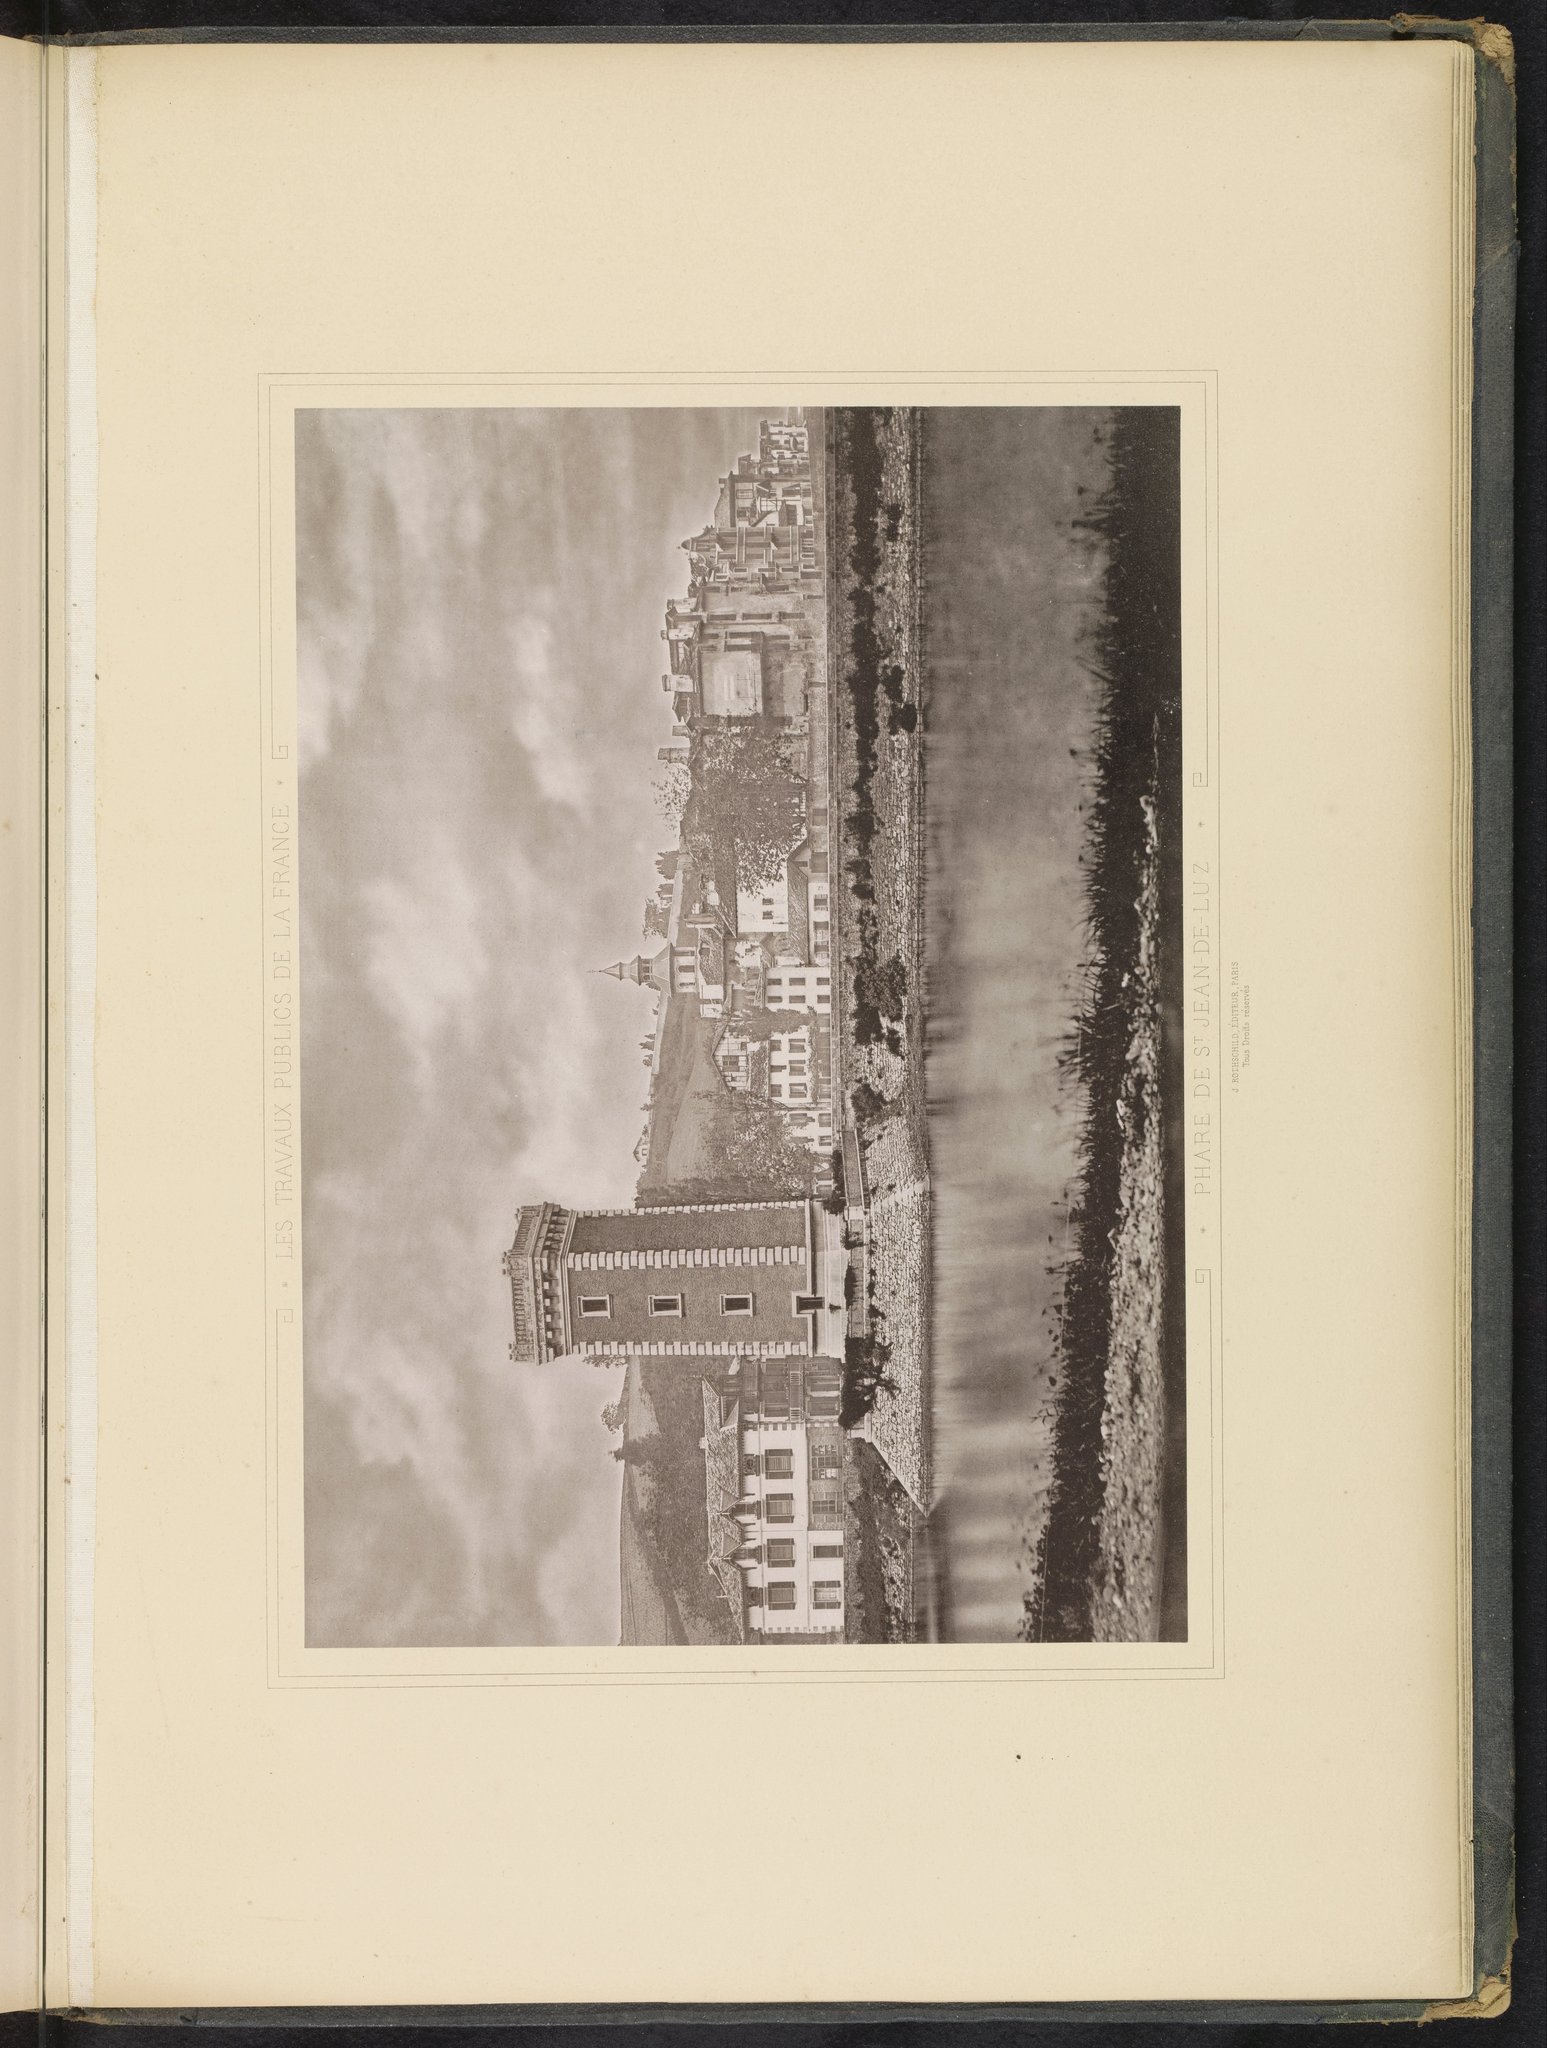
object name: photomechanical print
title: Phare de St Jean-de-Luz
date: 1873-1883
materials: paper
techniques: photograph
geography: paris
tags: lighthouse, lightship, city-view in general; 'veduta'